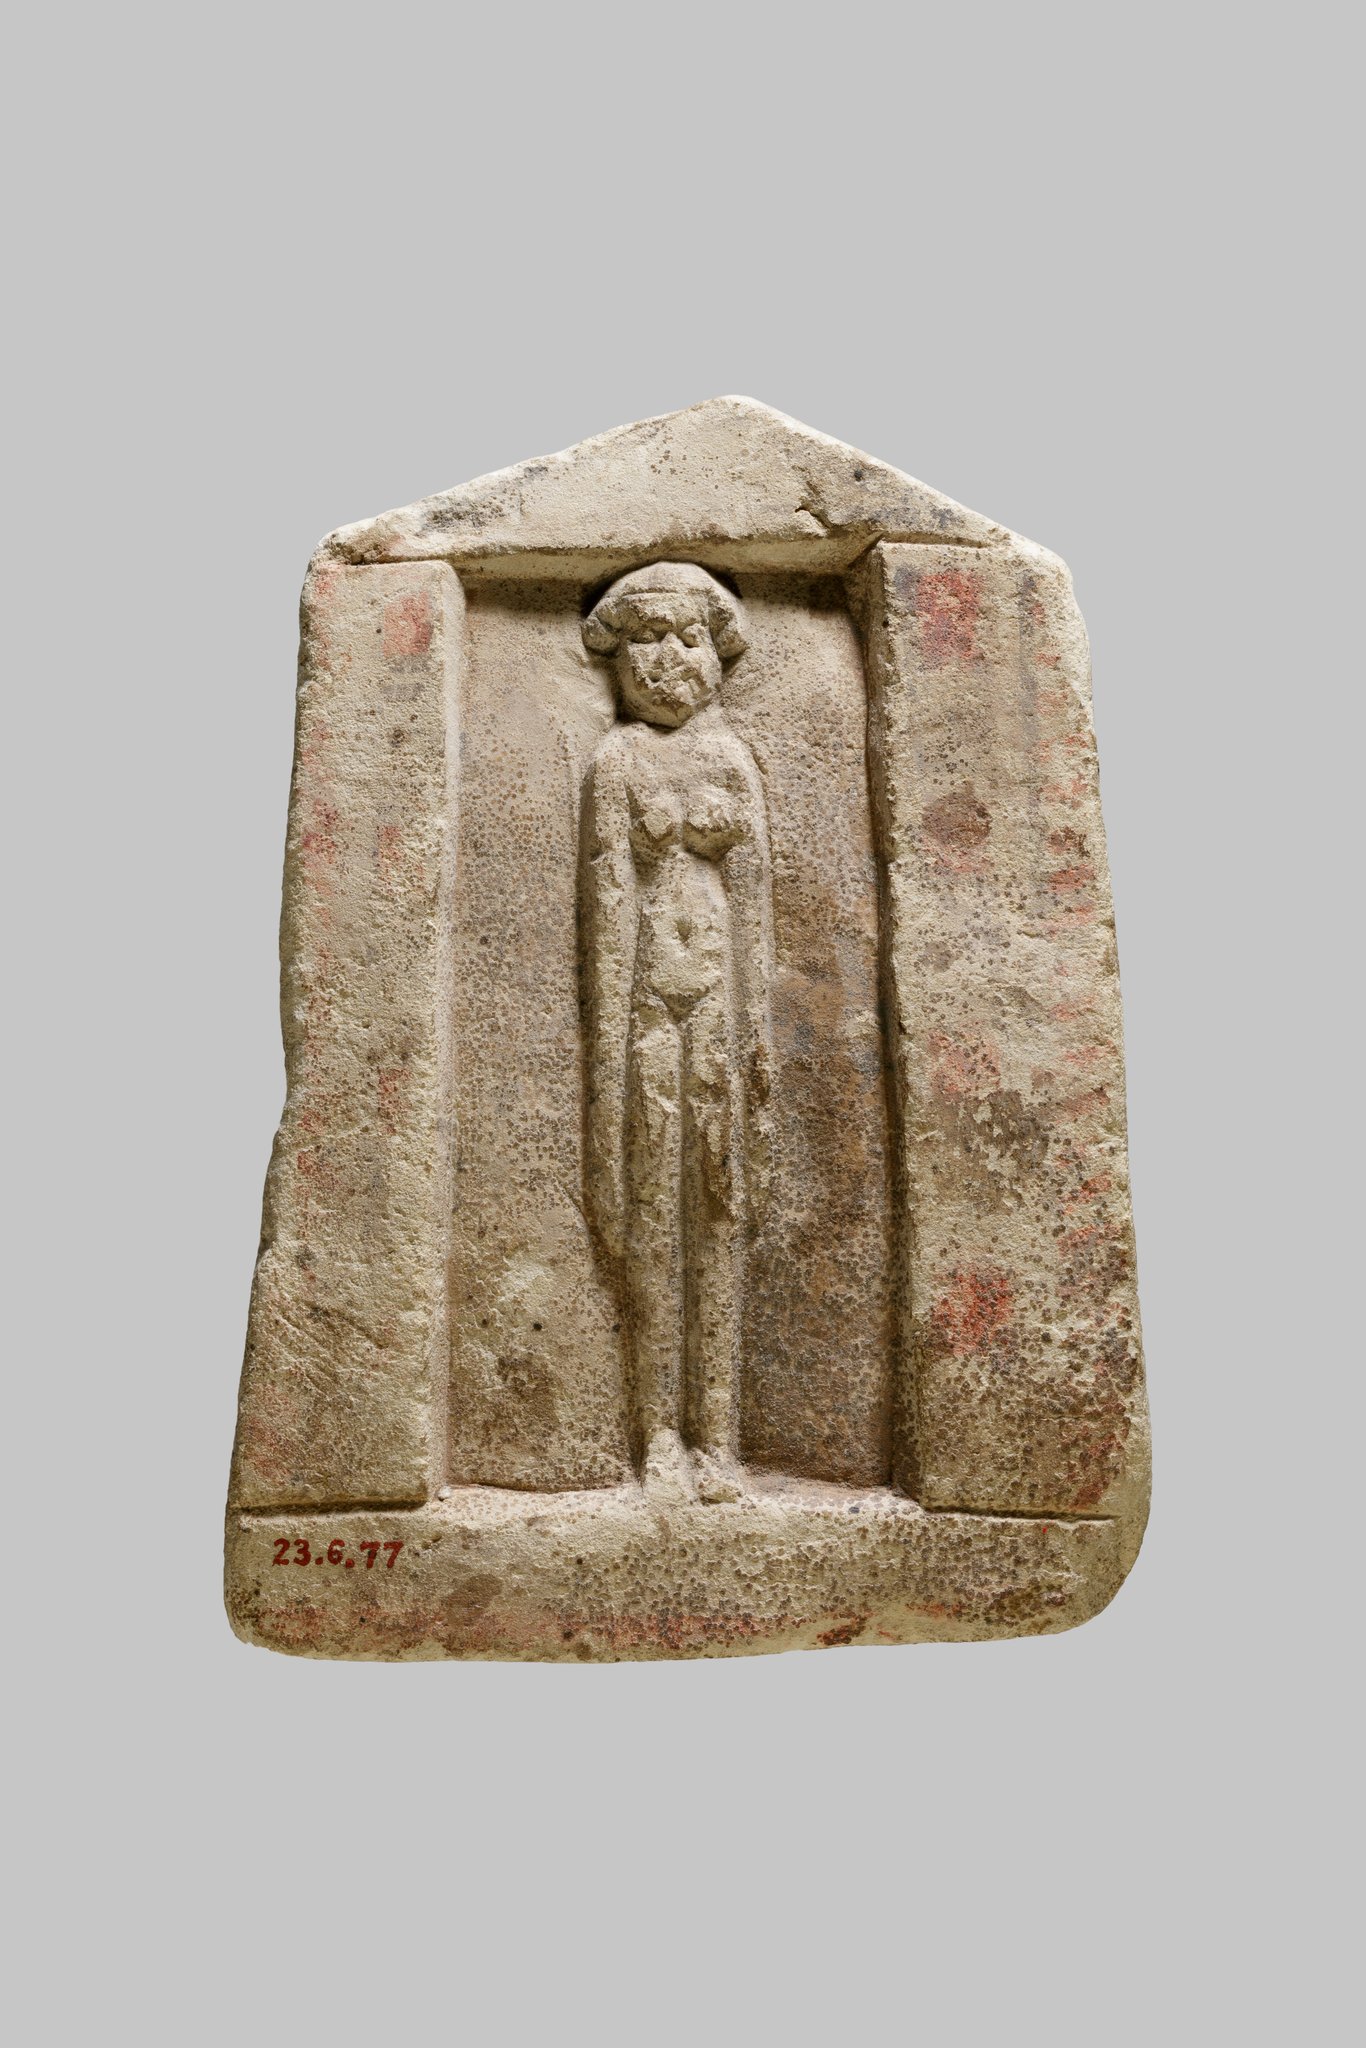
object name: stela, female figure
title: Plaque with nude female in a shrine niche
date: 600-275 BCE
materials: limestone, paint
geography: egypt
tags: female nudes